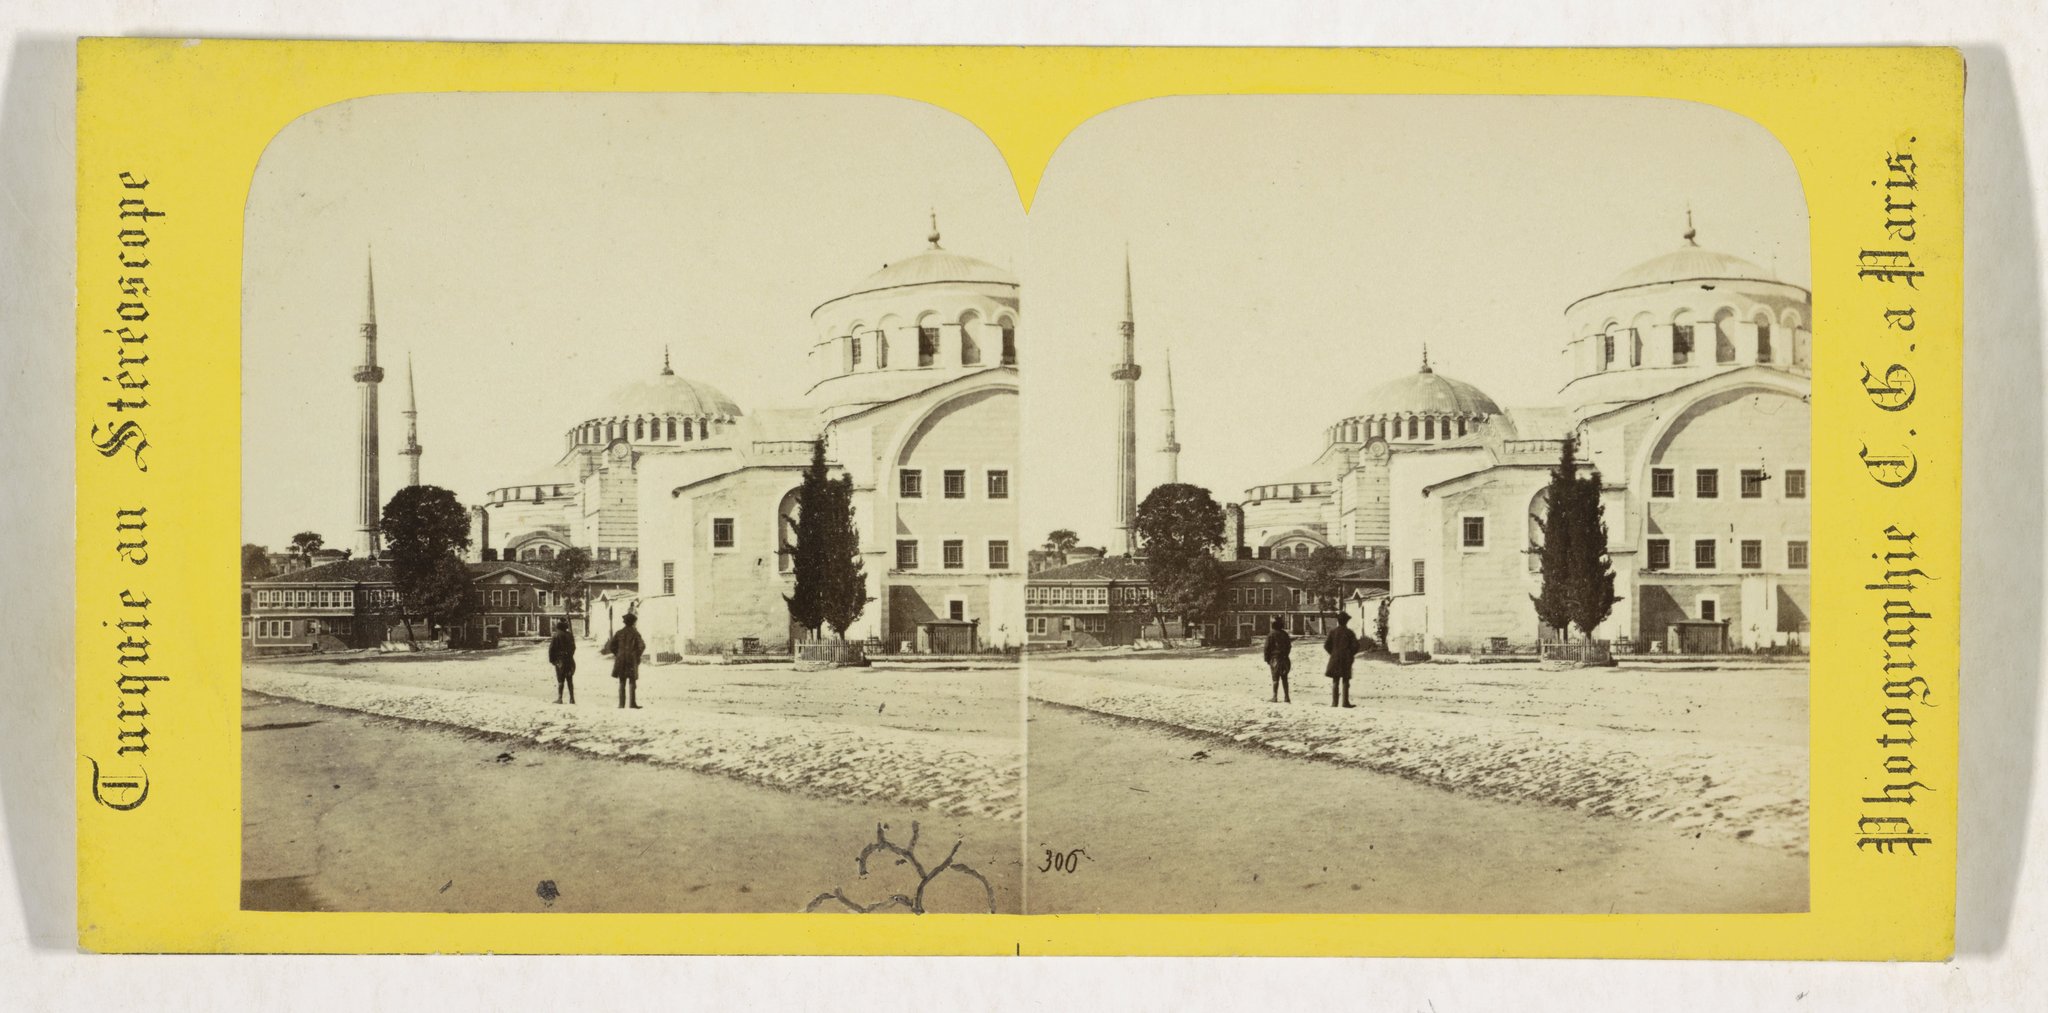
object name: stereograph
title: Hagia Irene en Hagia Sophia te Istanboel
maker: charles gaudin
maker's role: publisher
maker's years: 1825-1905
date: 1861-1870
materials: cardboard, paper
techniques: albumen print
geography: istanbul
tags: temple, shrine ~ islam, mohammedanism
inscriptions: number: ‘306’